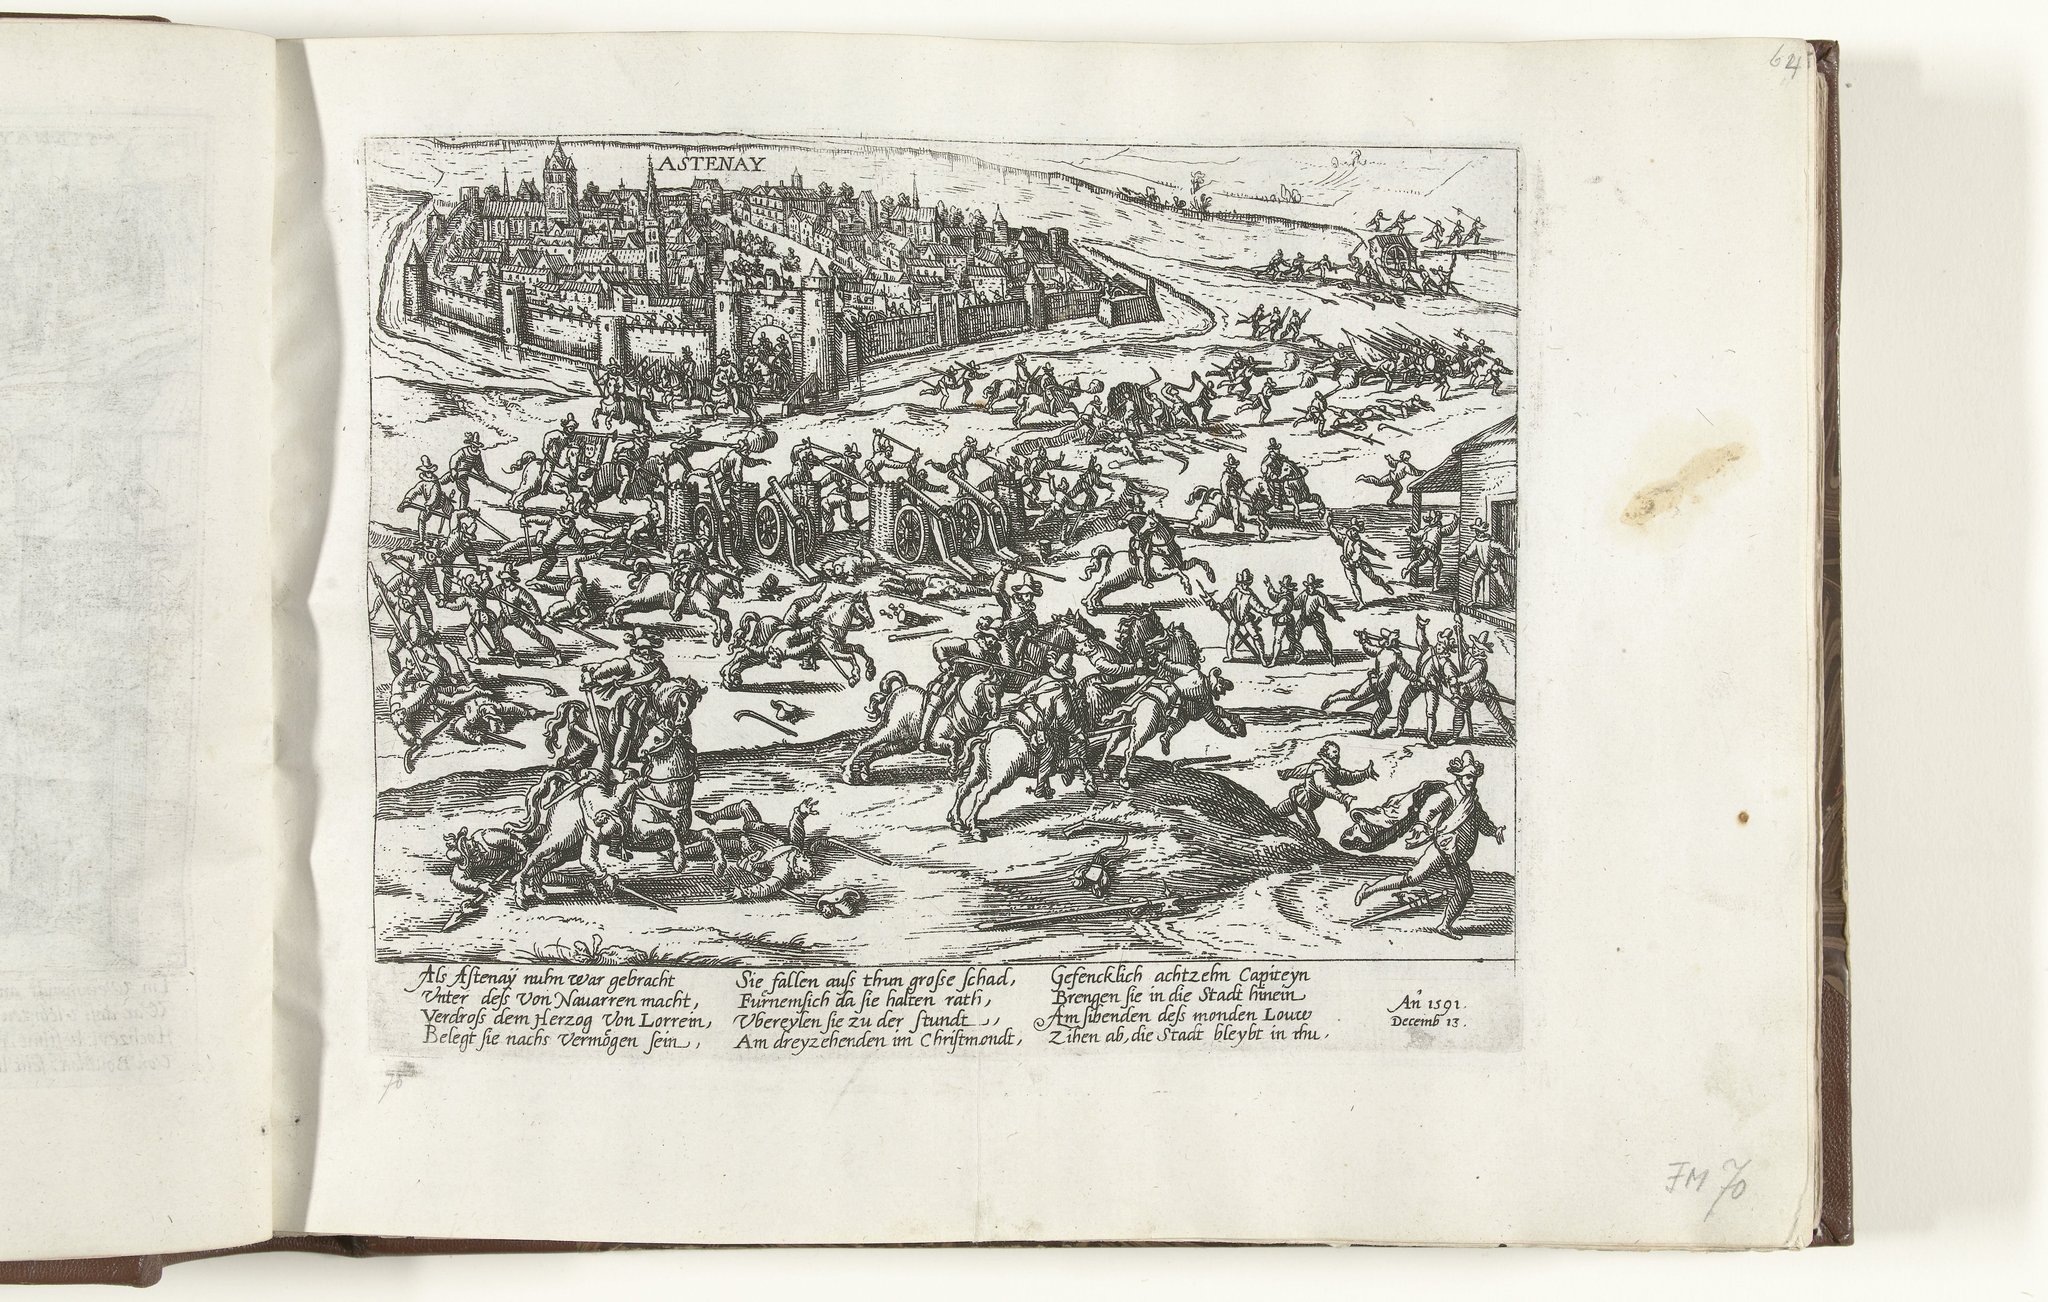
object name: album leaf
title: Serie 4: Franse, Duitse en Engelse Gebeurtenissen, 1576-1610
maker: frans hogenberg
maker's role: print maker, publisher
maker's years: 1538-1590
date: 1591-1612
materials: paper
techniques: etching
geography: cologne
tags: siege, position war, battle, fighting in general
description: Beleg van Stenay door de hertog van Lotharingen, 13 december 1591. Op de voorgrond gevechten van man tot man. Boven de ommuurde stad Astenay. Met onderschrift van 12 regels in het Duits. Ongenummerd.